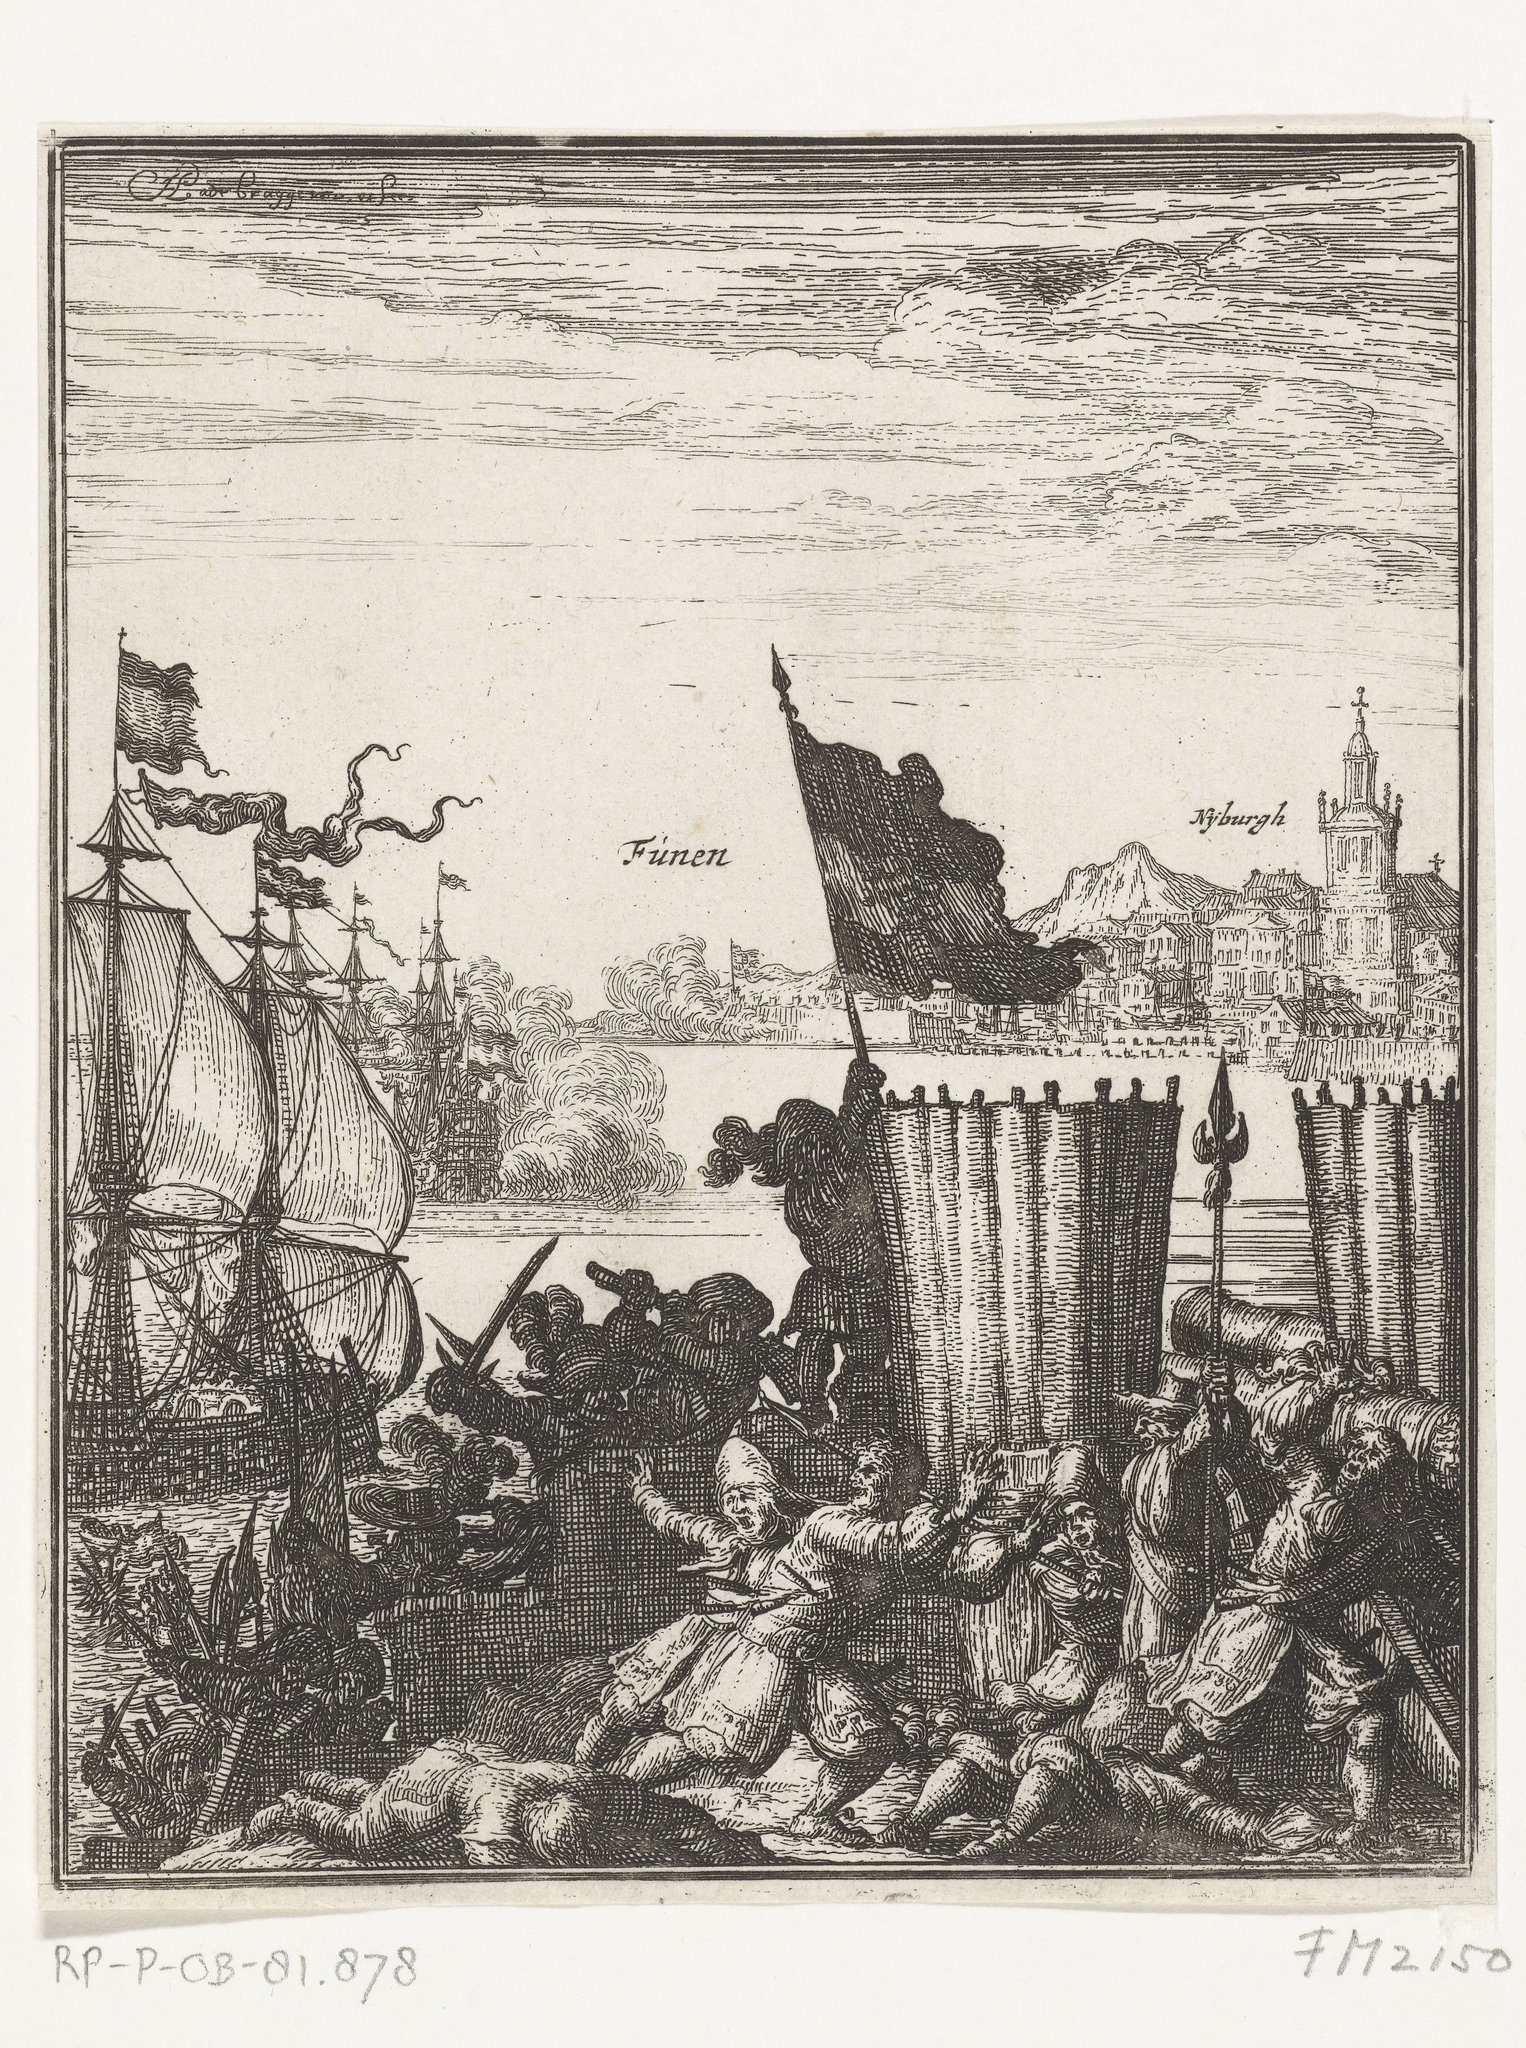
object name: history print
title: Verjagen van de Zweden uit een schans op Funen, 1659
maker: herman padtbrugge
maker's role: print maker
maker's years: 1656-1687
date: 1674-1676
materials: paper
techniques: etching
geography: northern netherlands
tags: flushing, michiel adriaenszoon de ruyter, battle (+ land forces)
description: Gebruikt als illustratie in: Lambertus van den Bosch, Leeven en daden der doorluchtighste zeehelden en ontdeckers van landen deser eeuwen, 2 dln, Jan Claesz ten Hoorn & Jan Bouman, Amsterdam 1676, dl. II, p. 184/185.